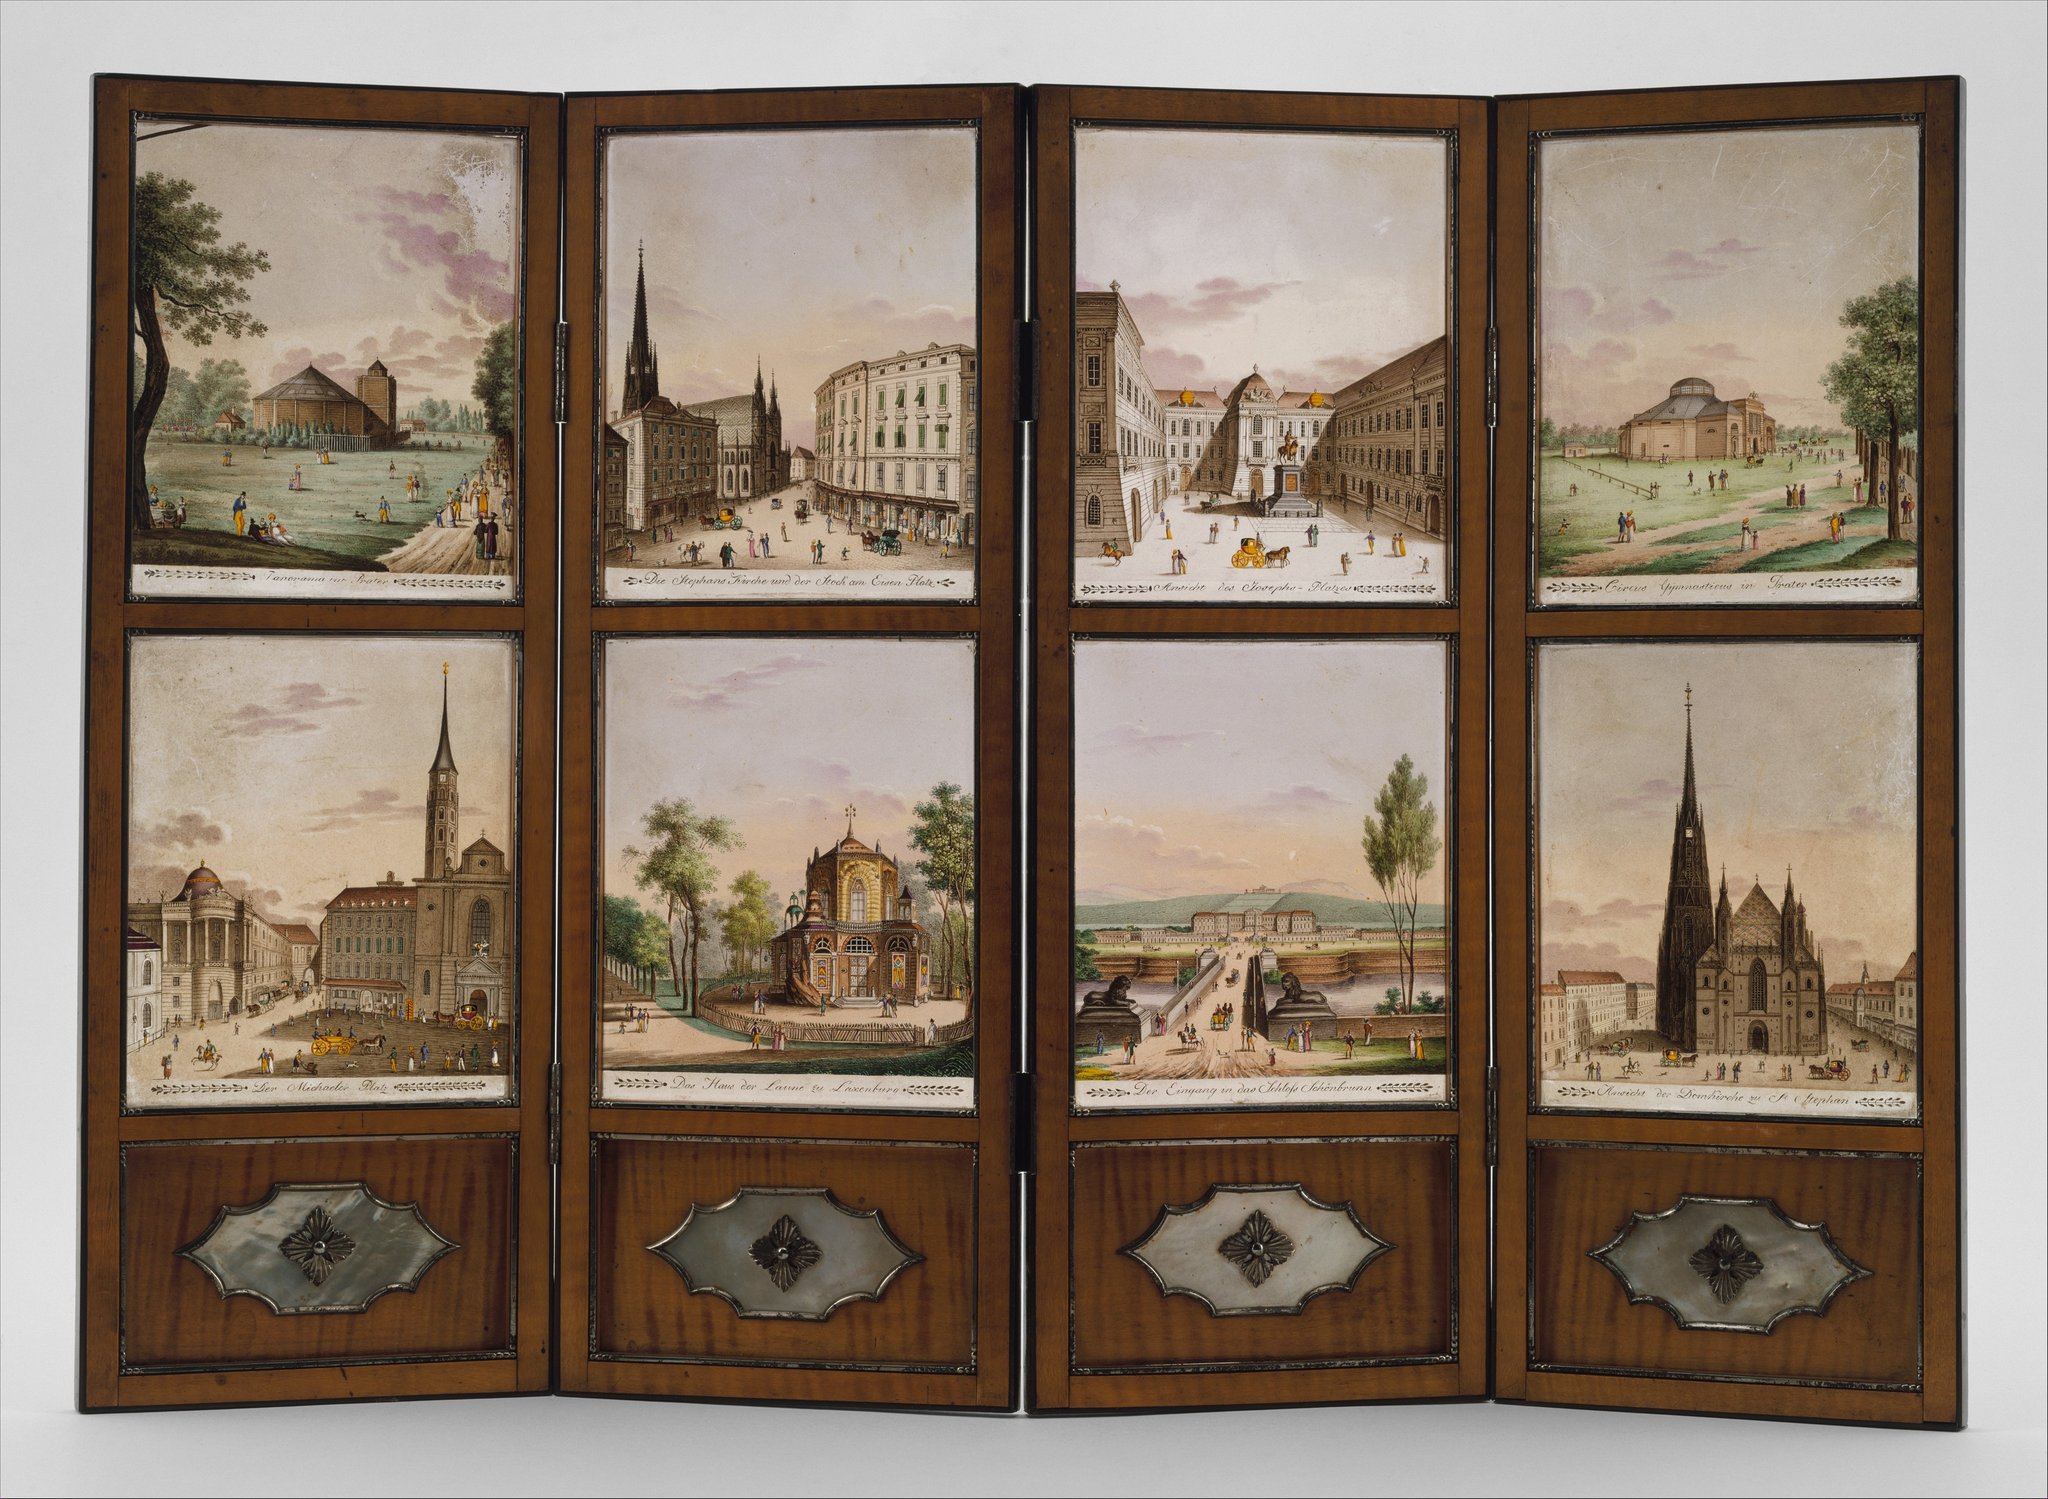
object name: light screen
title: Views of Vienna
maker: anton kothgasser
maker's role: enameler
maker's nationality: austrian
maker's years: 1769-1851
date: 1820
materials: glass, mother of pearl, steel, wood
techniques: enamel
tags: human figures,buildings,cities,streets